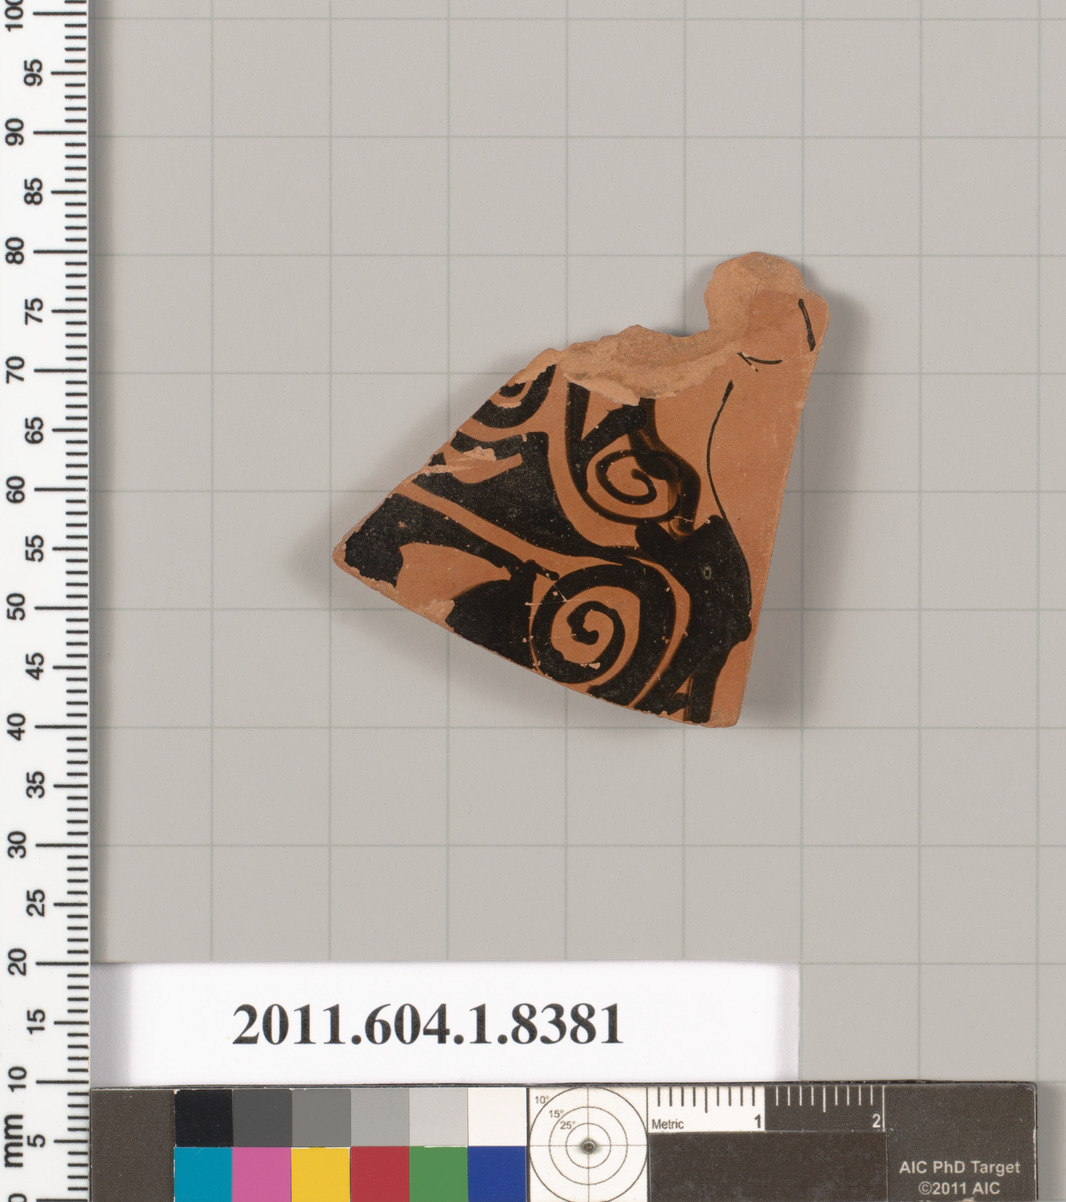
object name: kylix fragment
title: Terracotta fragment of a kylix (drinking cup)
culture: greek, attic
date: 400-351 BCE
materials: terracotta